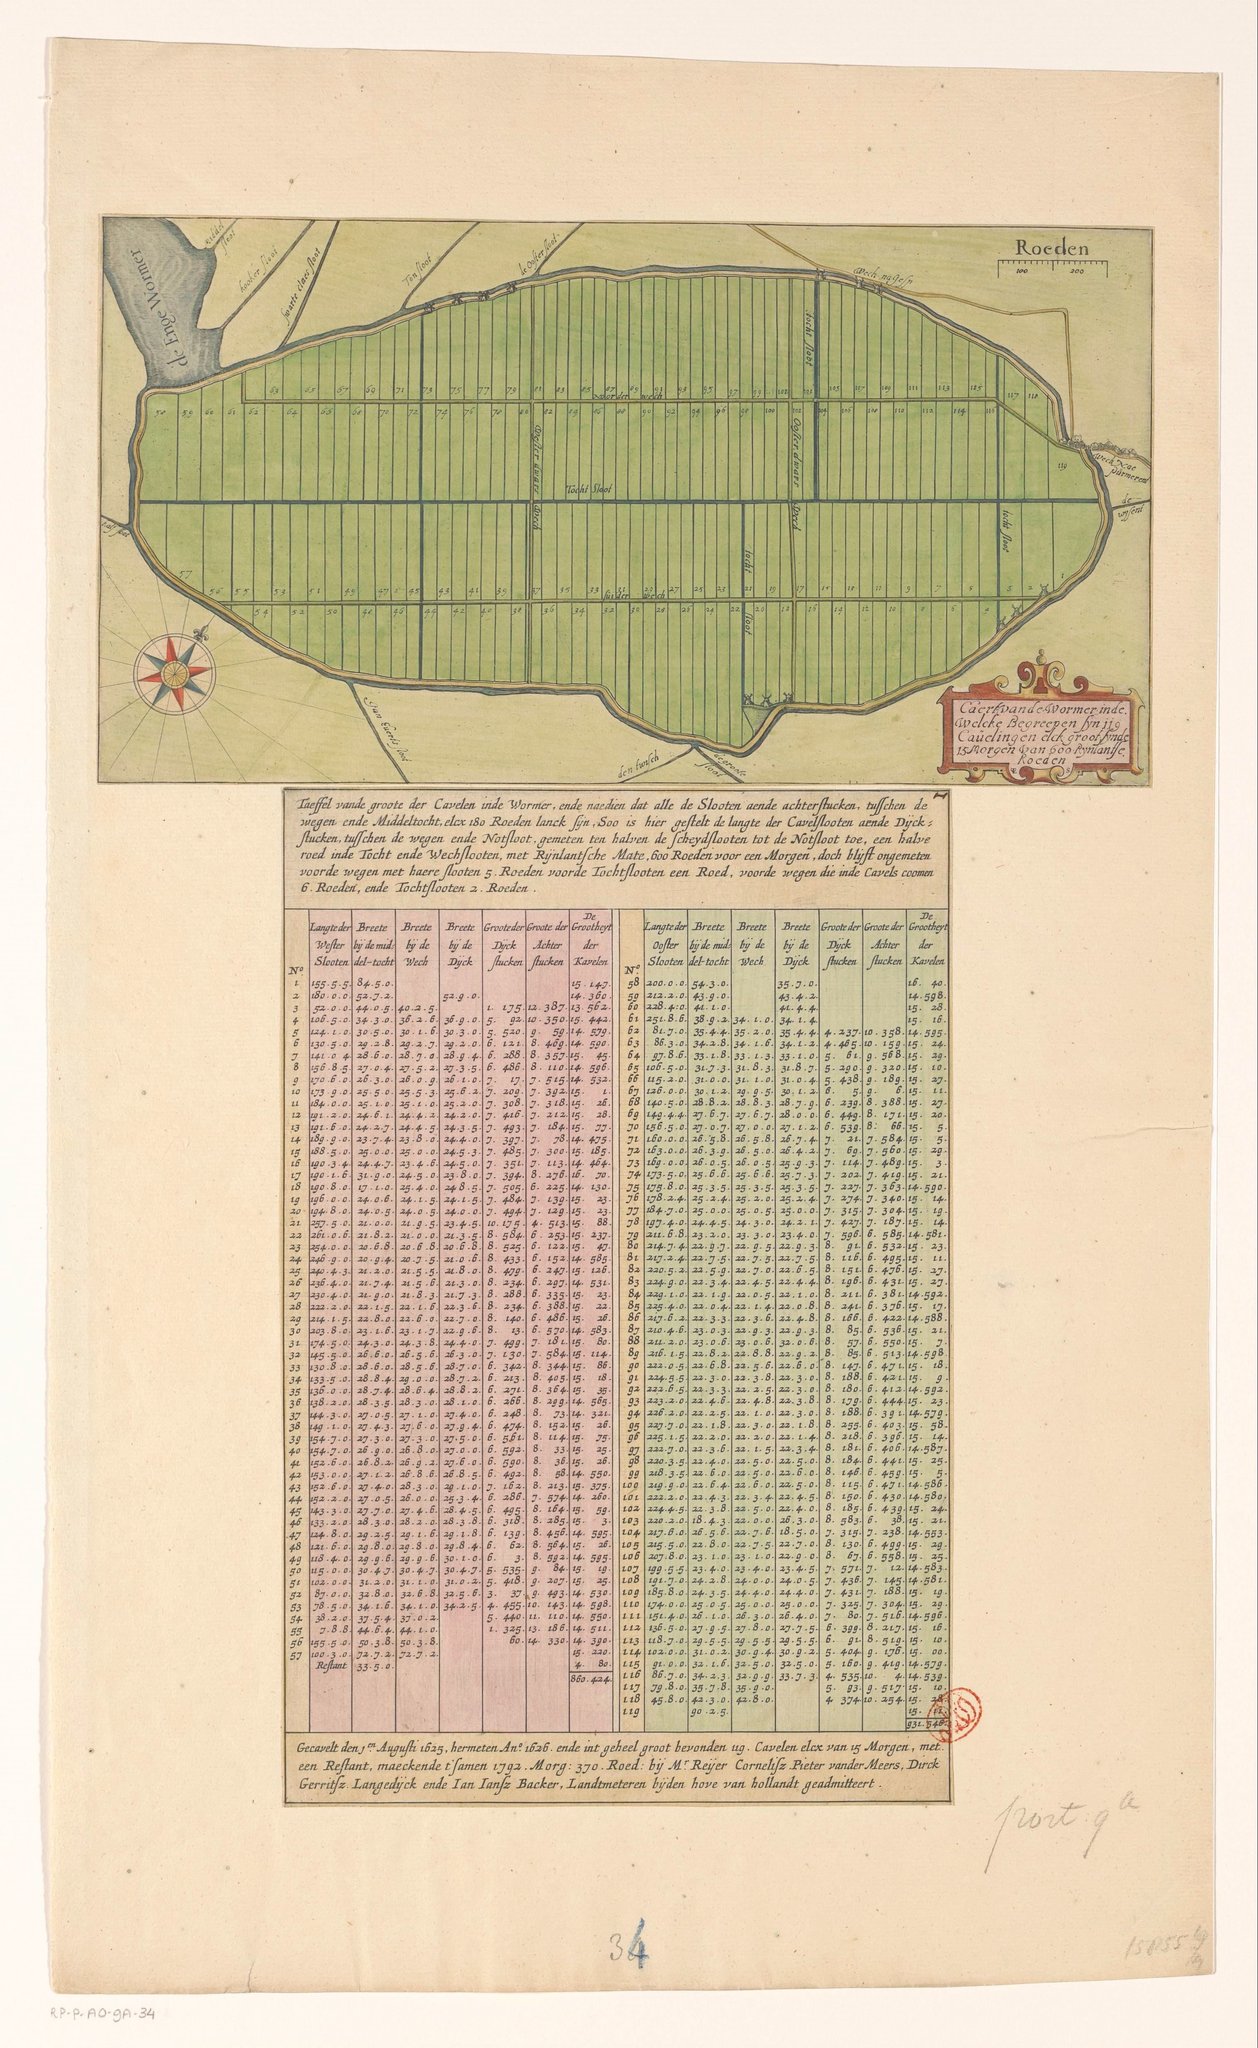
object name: map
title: Kaart en tabel met de kavels van de Wormer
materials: paper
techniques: engraving, hand coloring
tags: coat of arms (as symbol of the state, etc.) (+ city; municipal), maps of separate countries or regions, polder, reclaimed land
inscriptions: collector's mark: Lugt 195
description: Blad met daarop boven een kaart van de polder de Wormer, oftewel Wijdewormer, met kavelverdeling. Op de kaart rechtsonder de titelcartouche en rechtsboven een schaalstok: 200 roeden. De Engewormer is hier nog niet drooggelegd (1638). Onder de kaart een uitgebreide tabel met informatie over de 119 op de kaart genummerde kavels.